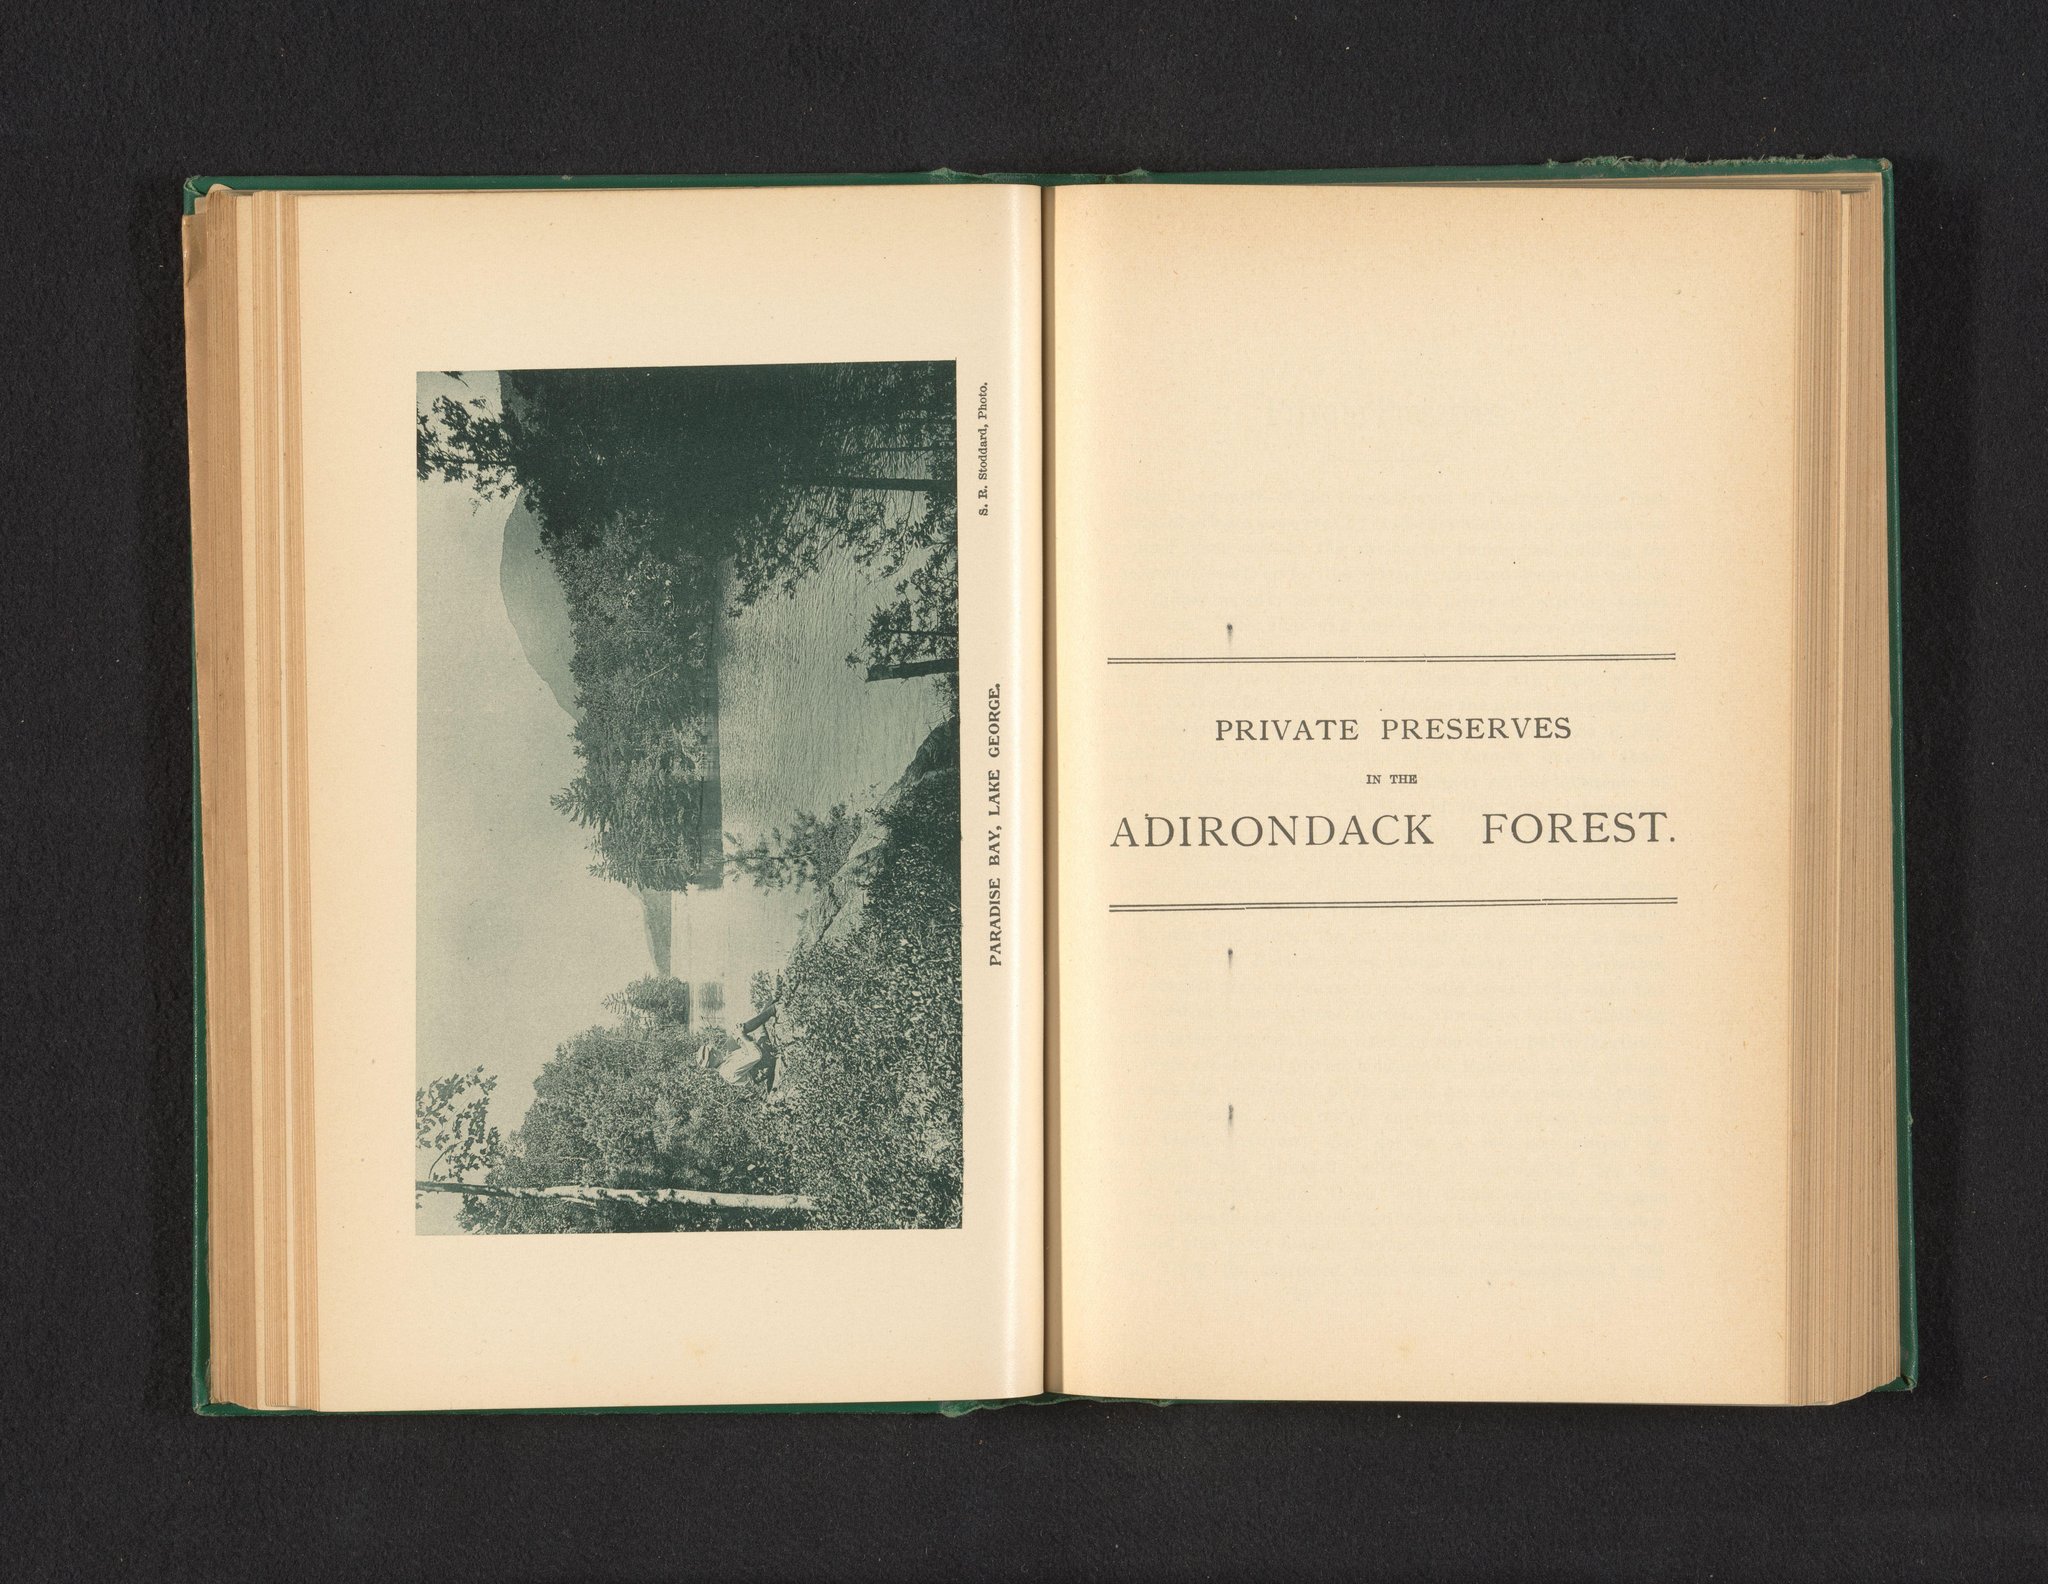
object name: photomechanical print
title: Paradise Bay, Lake George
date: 1893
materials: paper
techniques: photograph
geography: new york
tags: lake